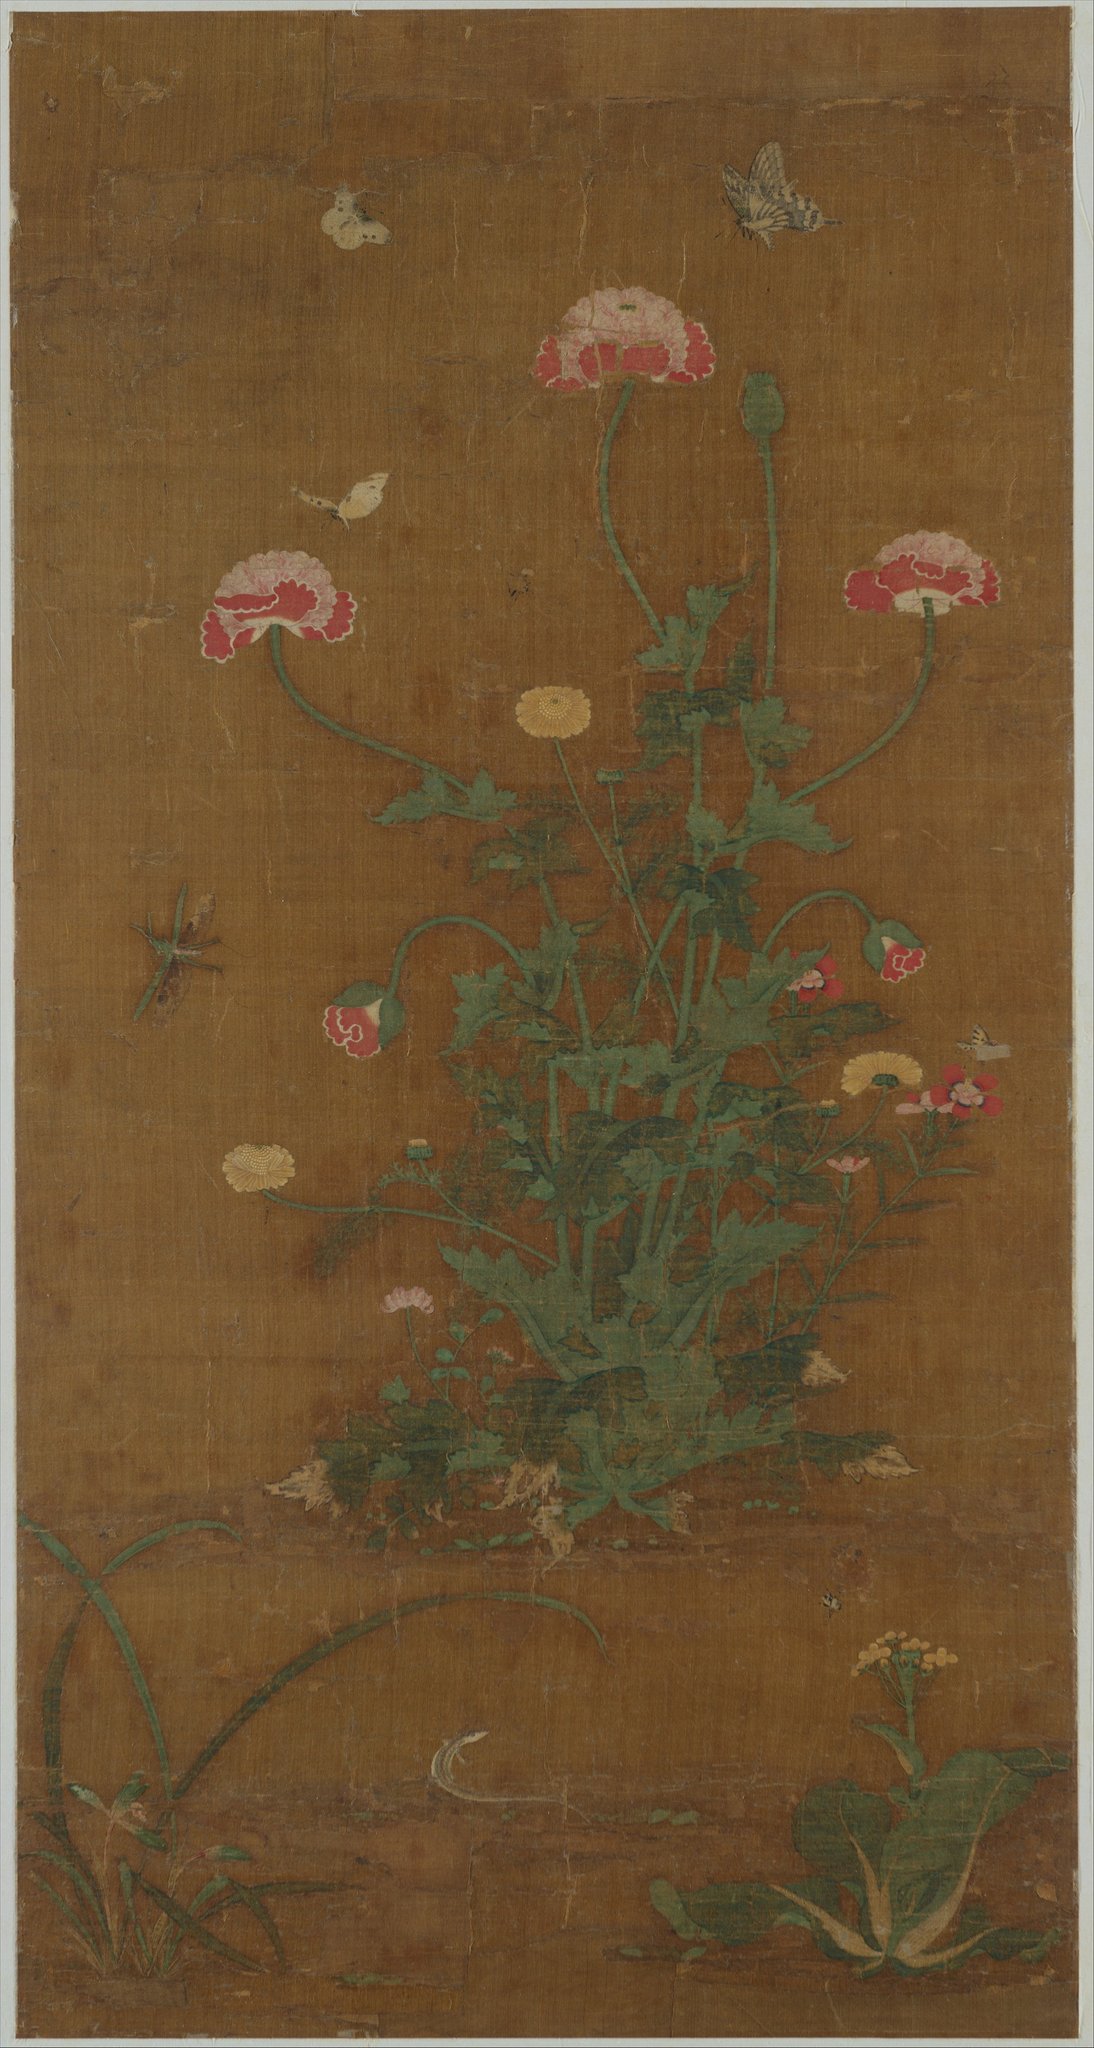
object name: hanging scroll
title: Flowers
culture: chinese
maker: lü jingfu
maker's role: artist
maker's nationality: chinese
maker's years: 1367-1399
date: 1301-1400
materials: ink, silk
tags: butterflies,flowers